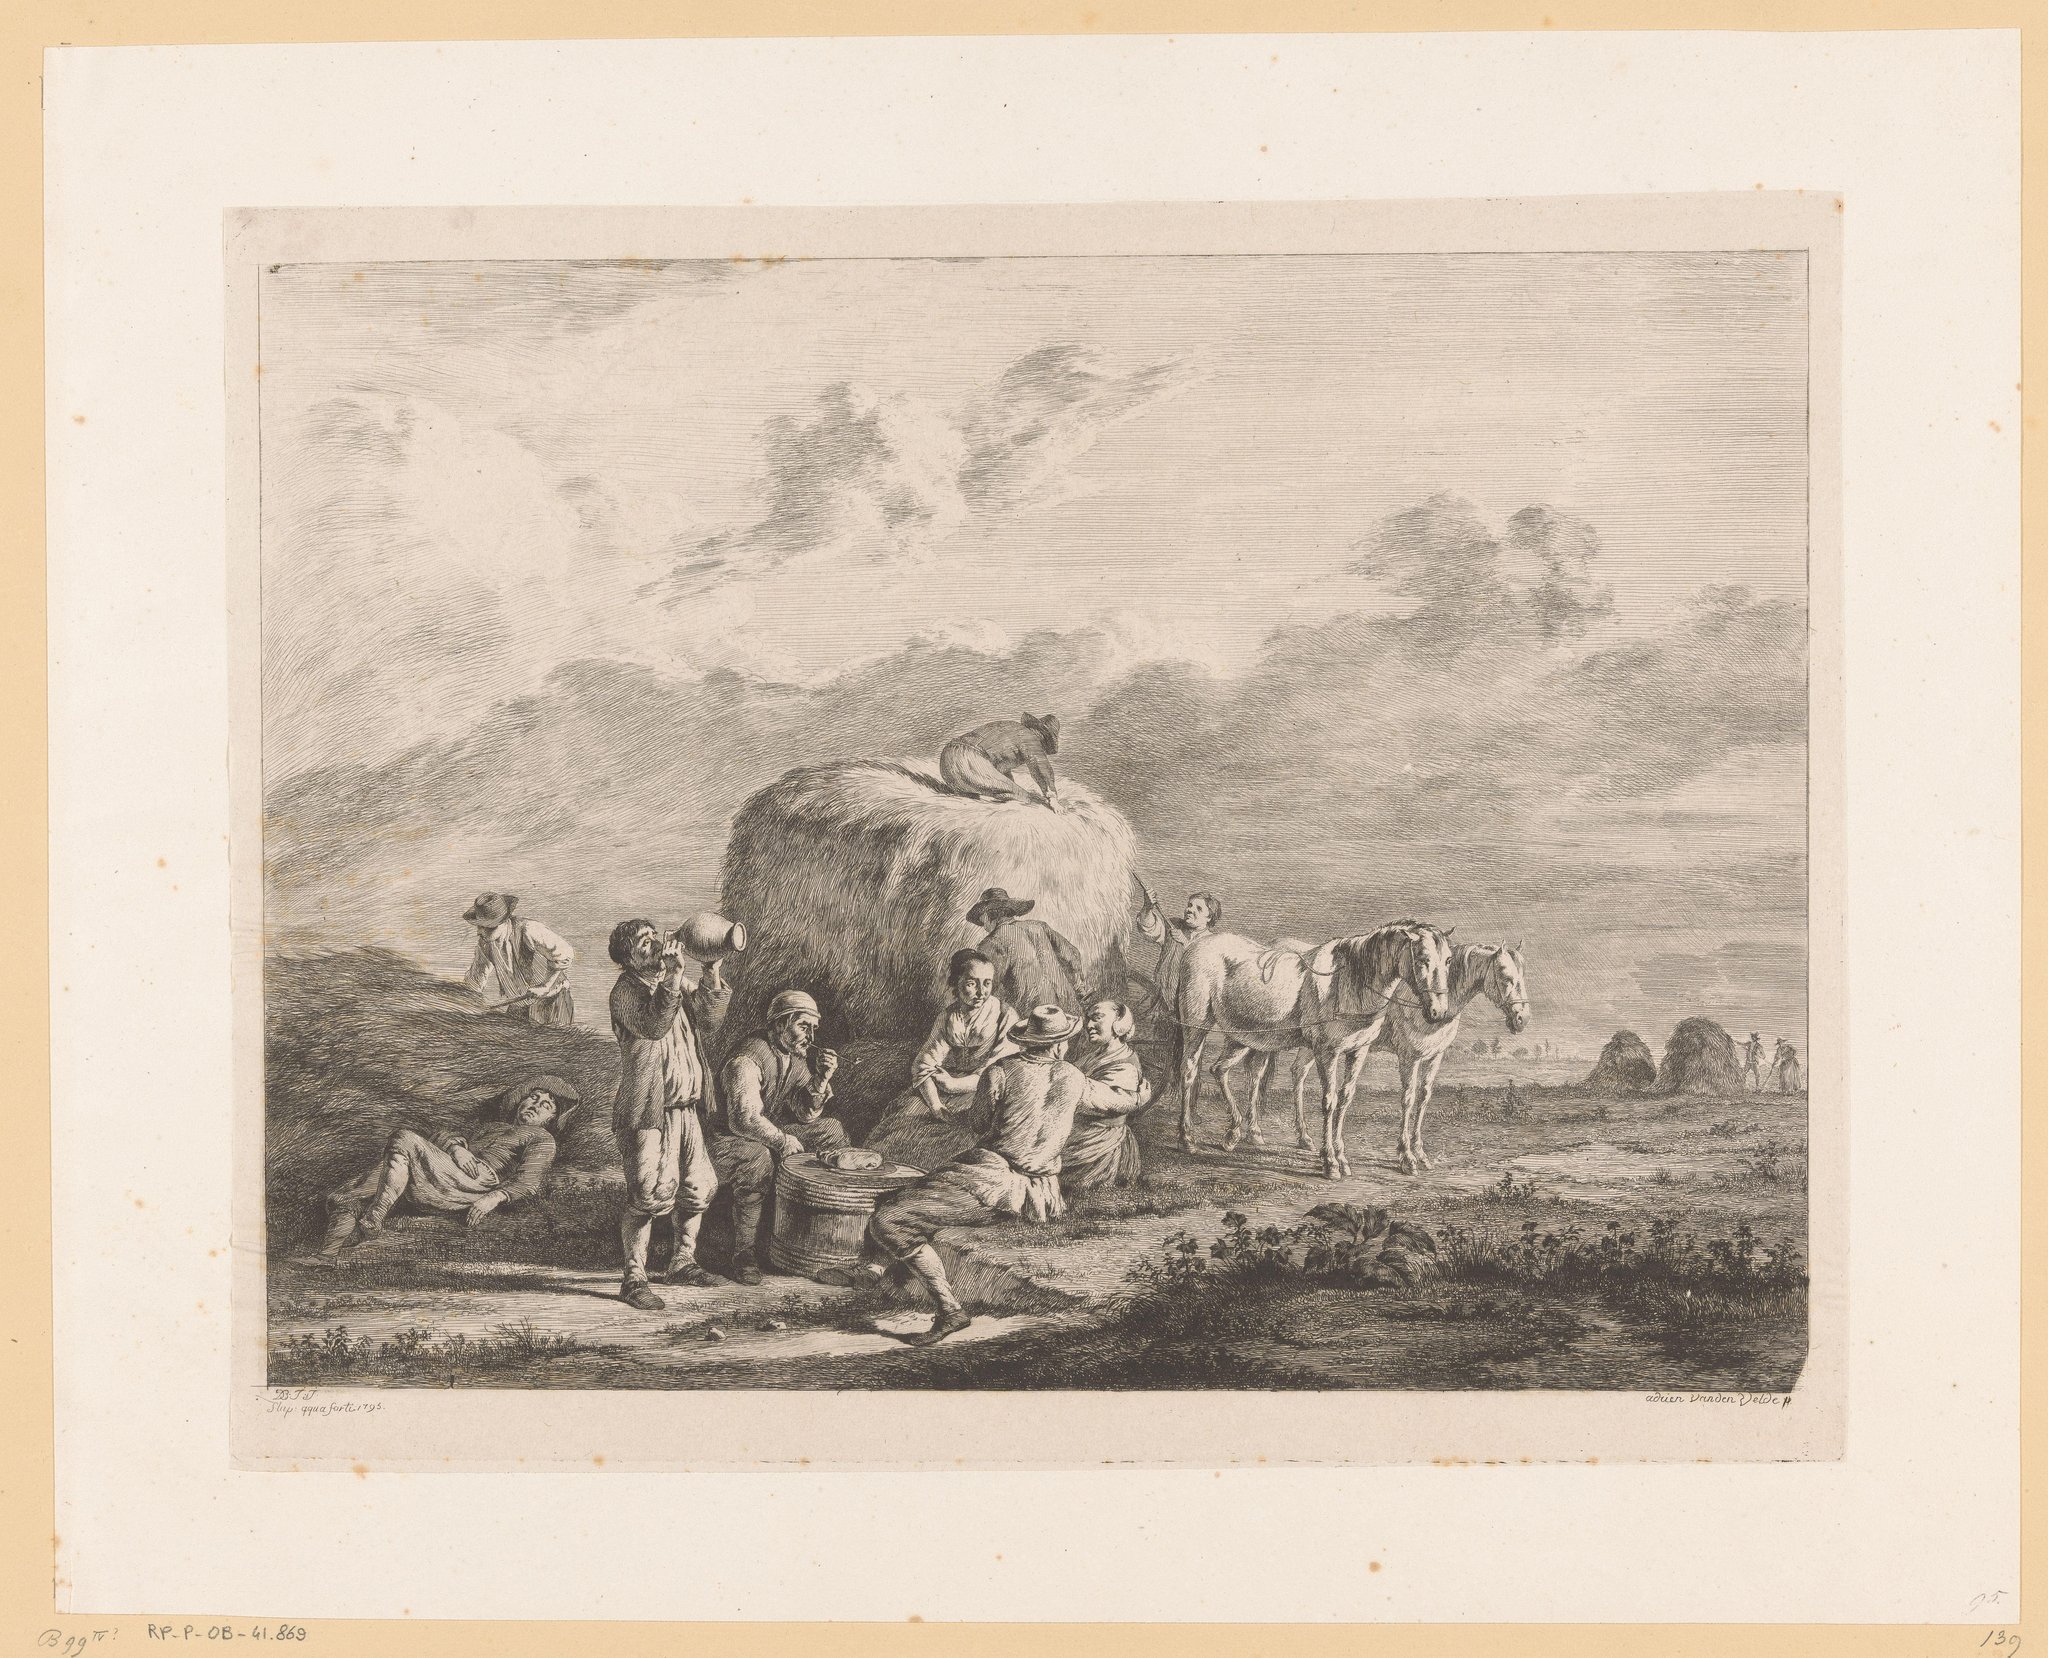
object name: print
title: Rustende maaiers op een veld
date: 1795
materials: paper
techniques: drypoint, etching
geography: france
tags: rest during harvest (eating, dancing, making love, etc.), reaping, picking, mowing ~ harvest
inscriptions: collector's mark: Lugt 12